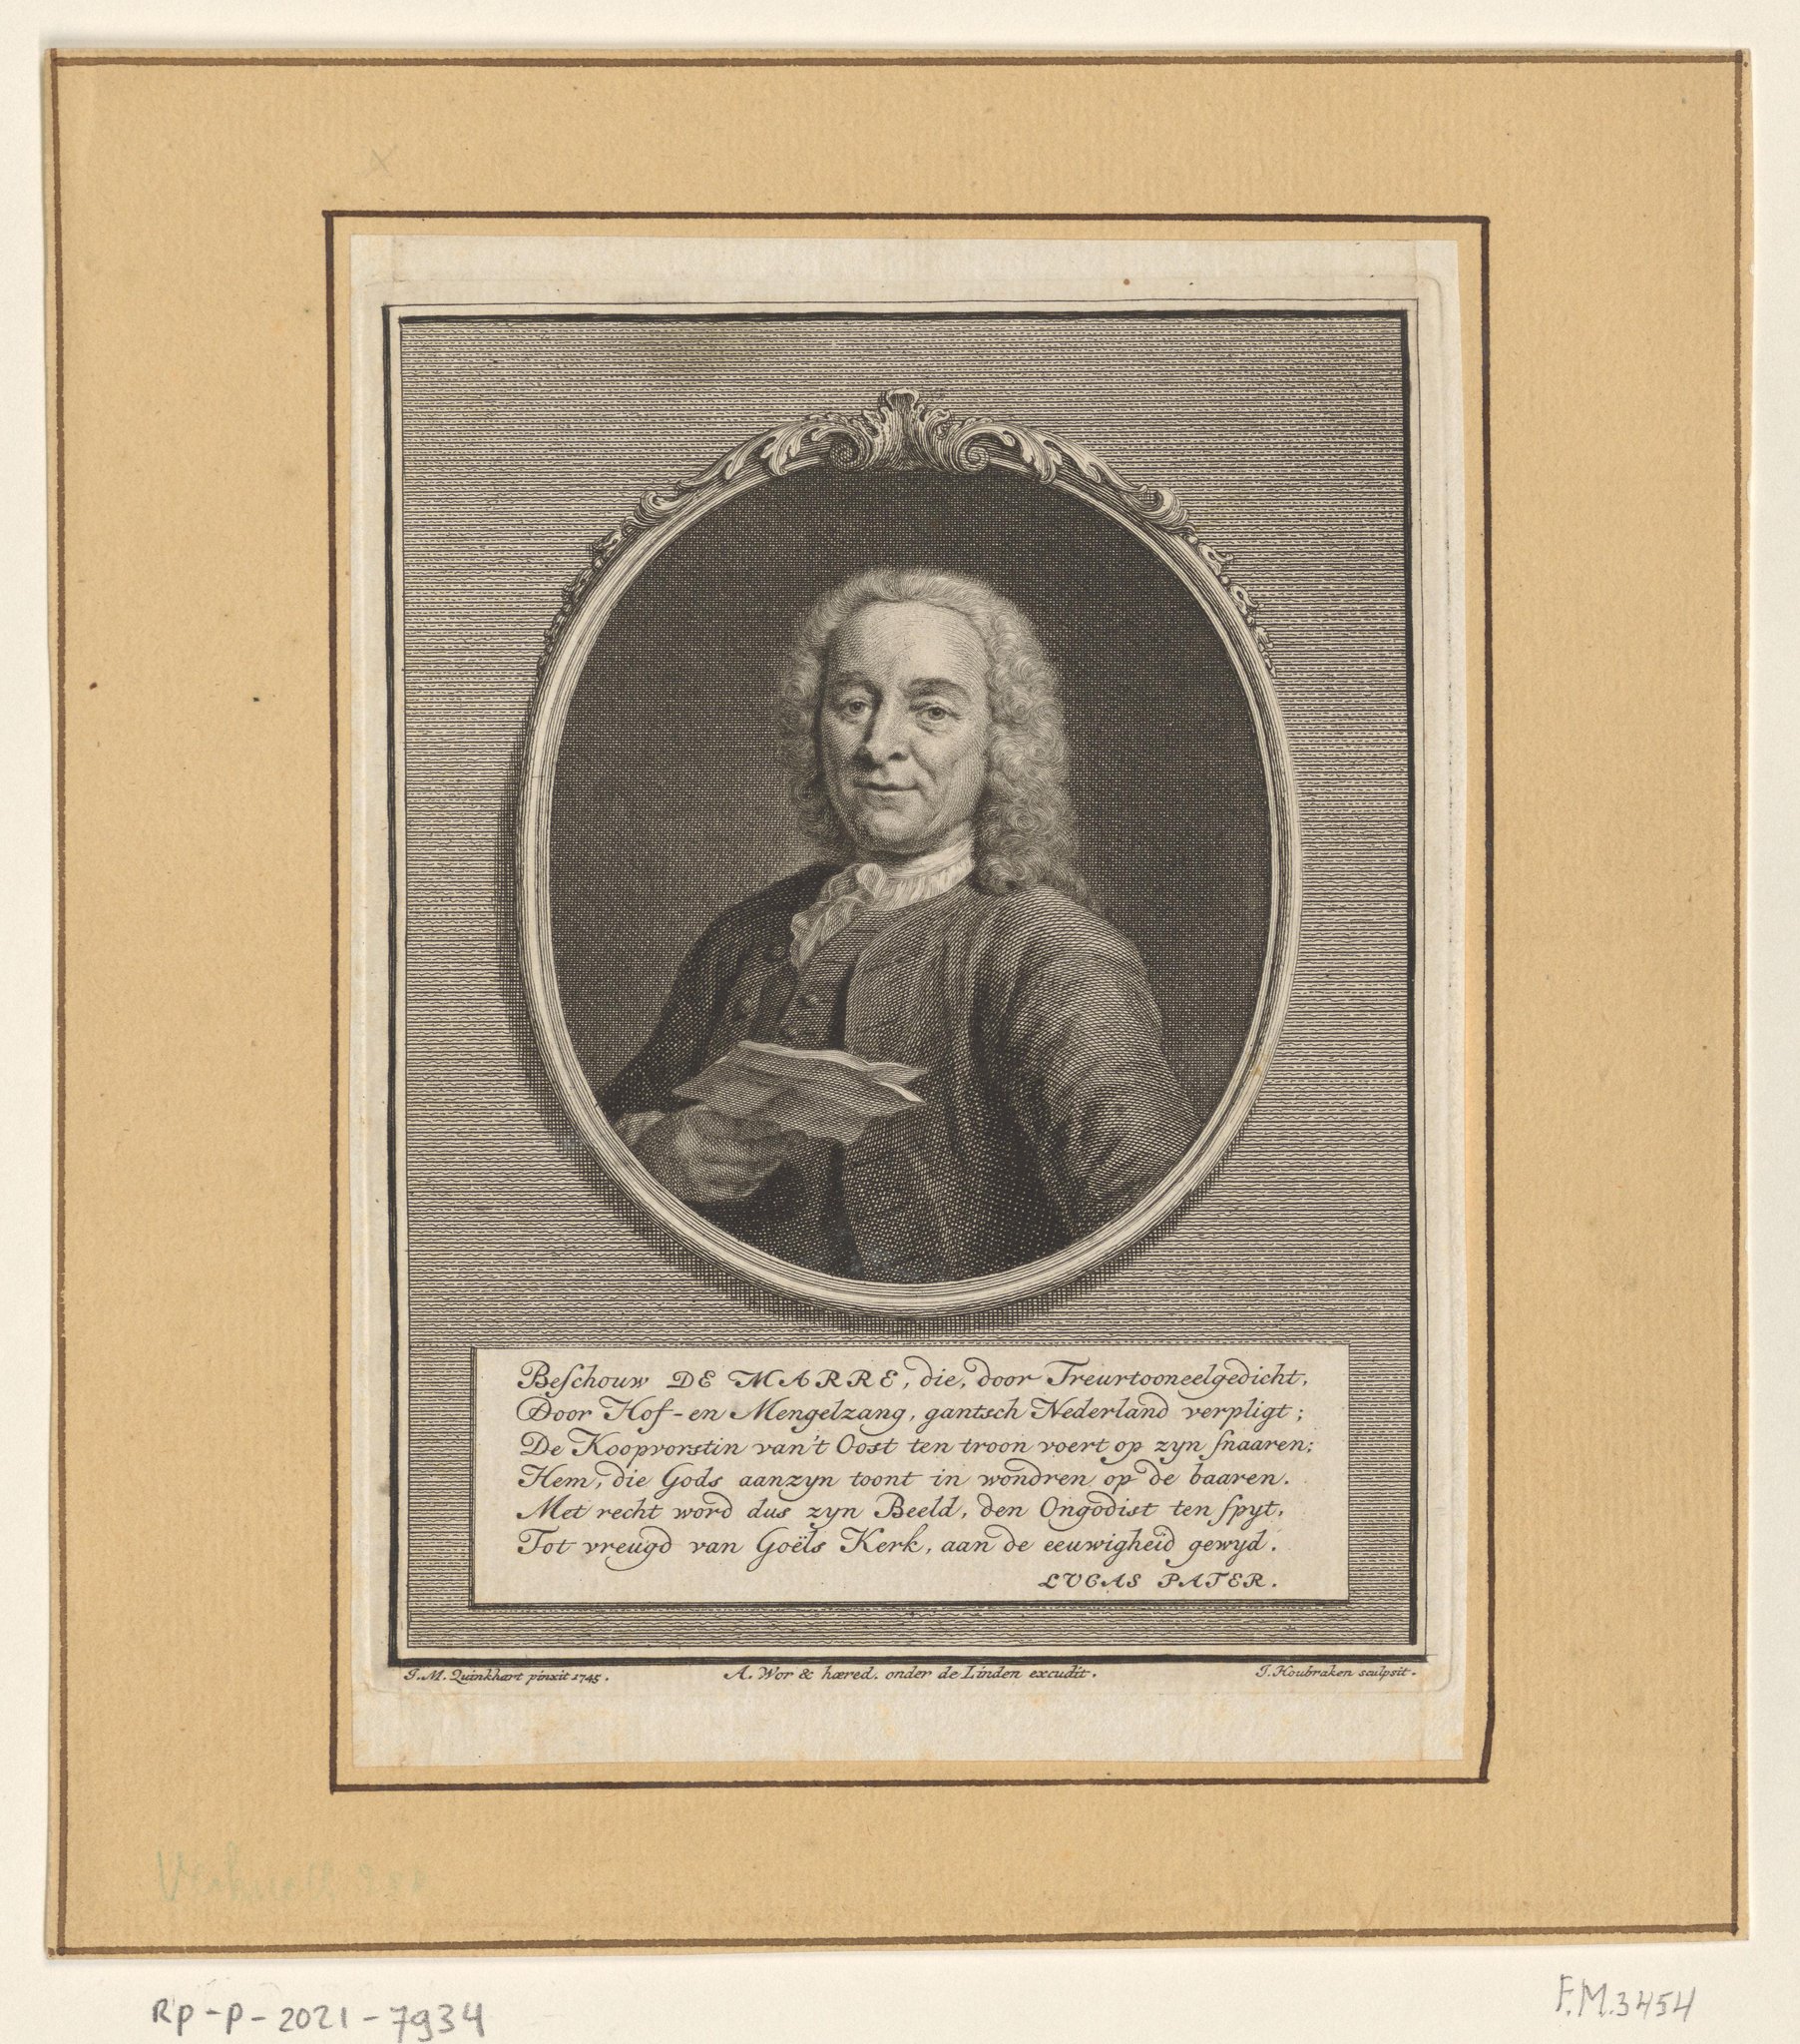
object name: print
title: Portret van Jan de Marre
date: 1745-1750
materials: paper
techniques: engraving, etching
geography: amsterdam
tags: ornament ~ medallion, historical persons, portrait of a writer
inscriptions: collector's mark: ‘Collectie/ Dr. J.G. de Lint.’